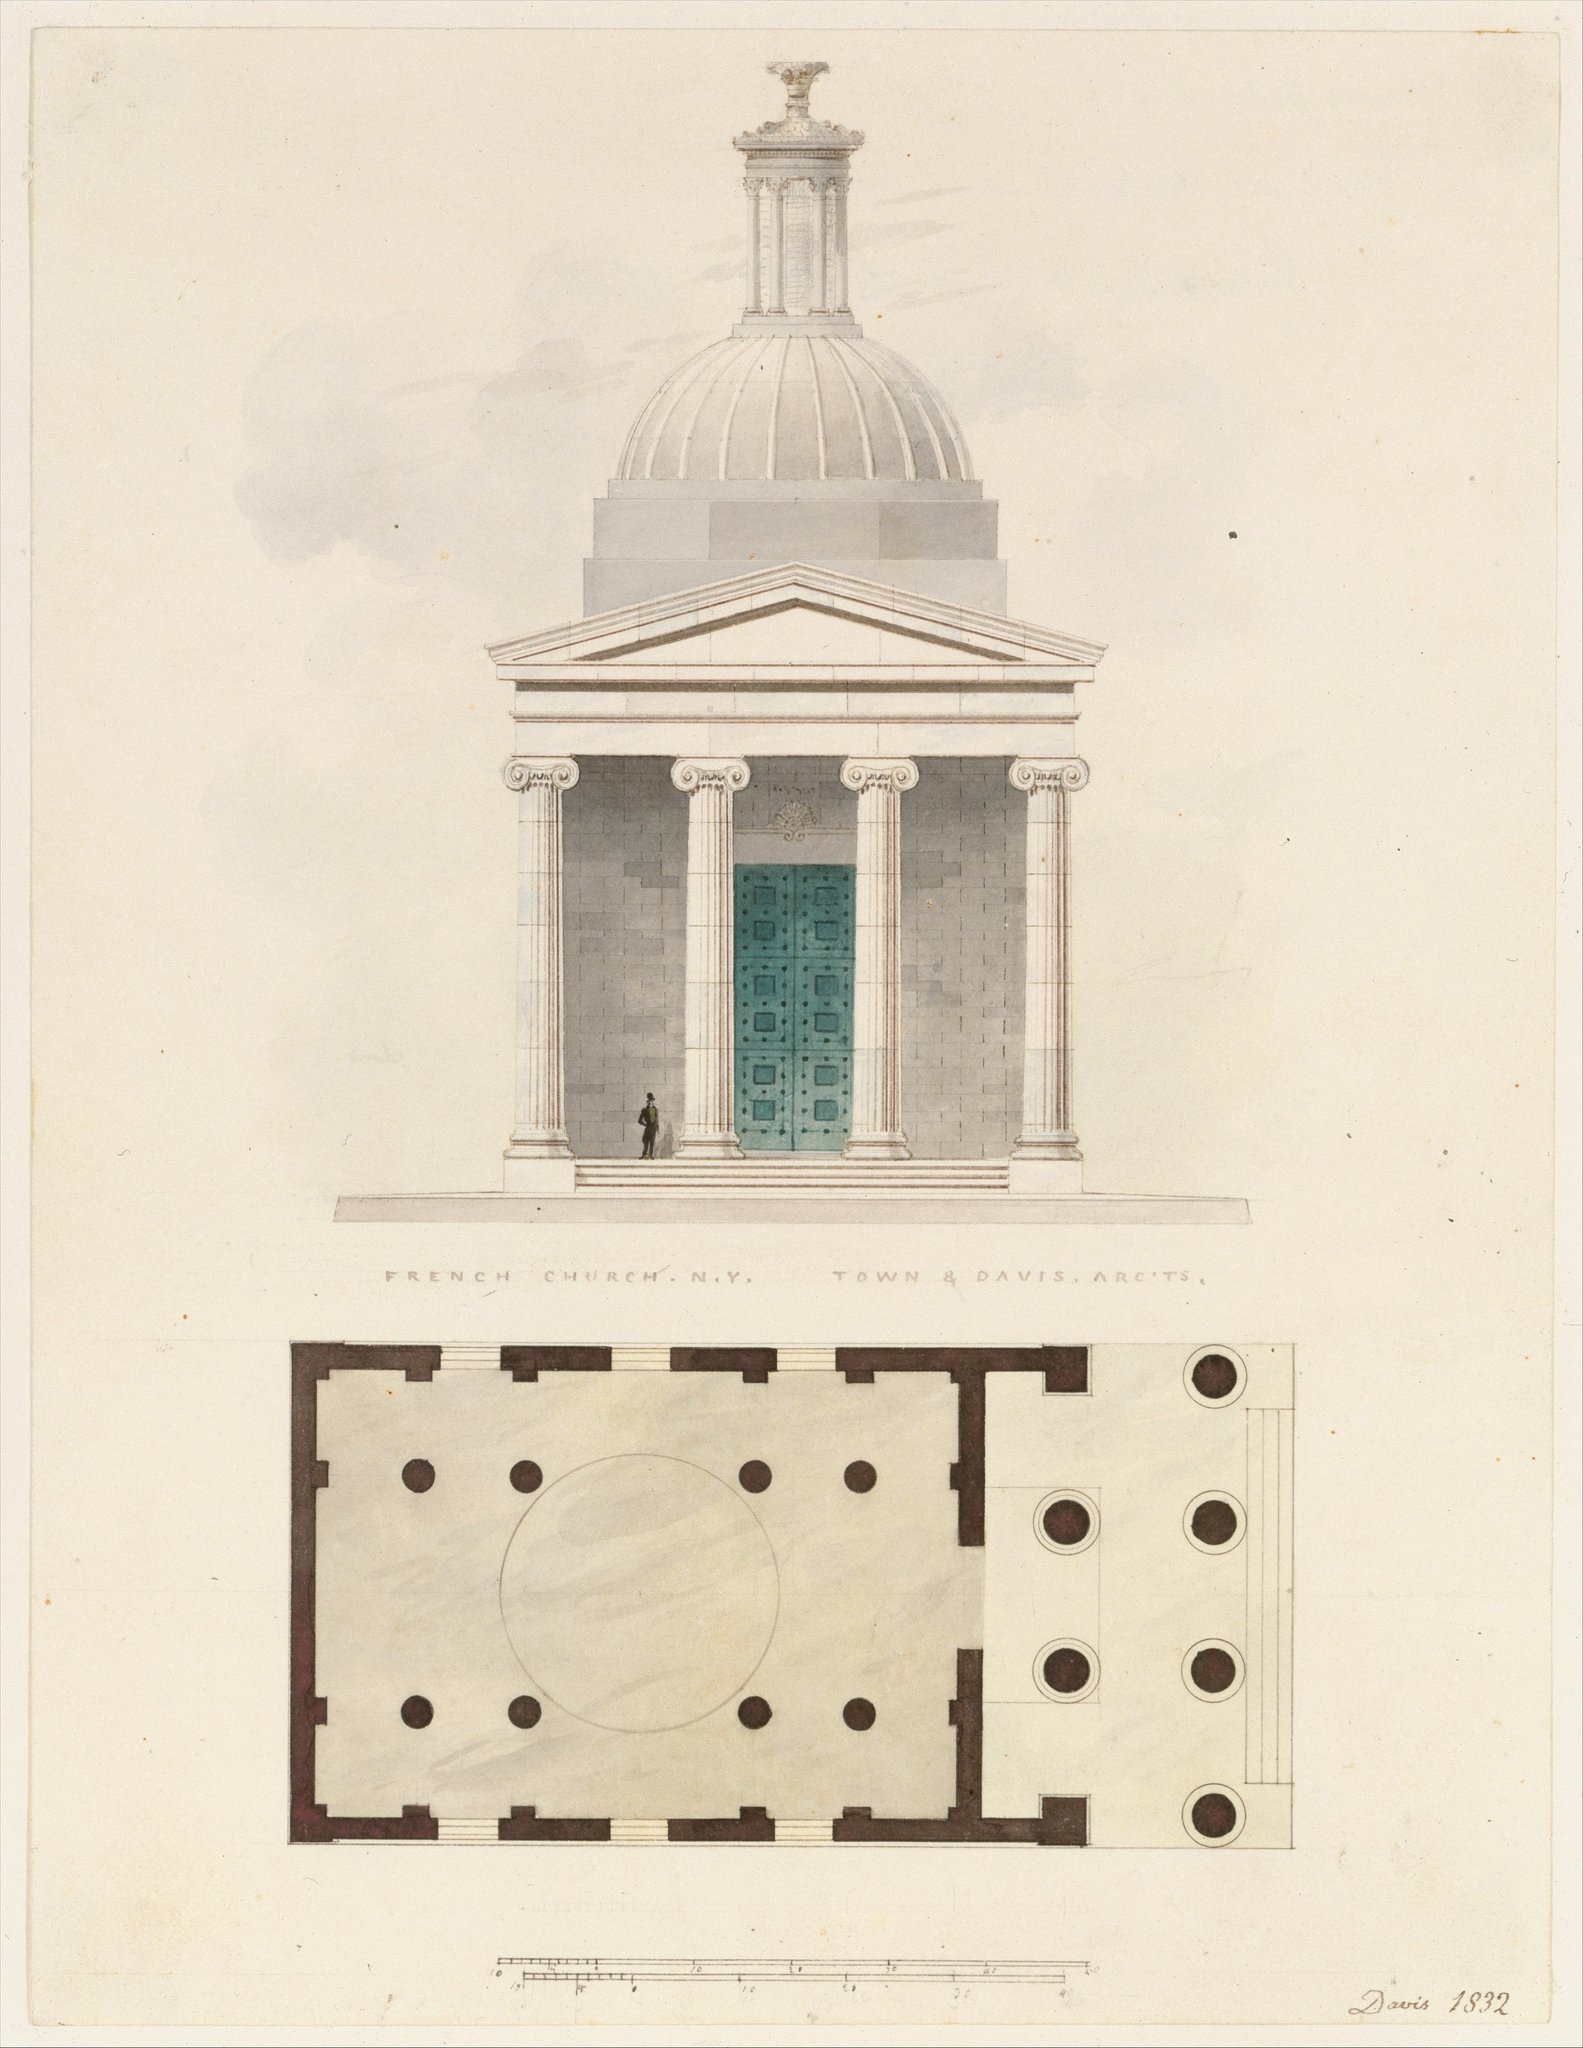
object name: drawing ornament architecture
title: Church of the French Protestants (Eglise Français du Saint Esprit), New York (front elevation and plan)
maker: alexander jackson davis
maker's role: artist and architect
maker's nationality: american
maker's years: 1803-1892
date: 1832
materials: graphite, ink, watercolor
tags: architecture,churches